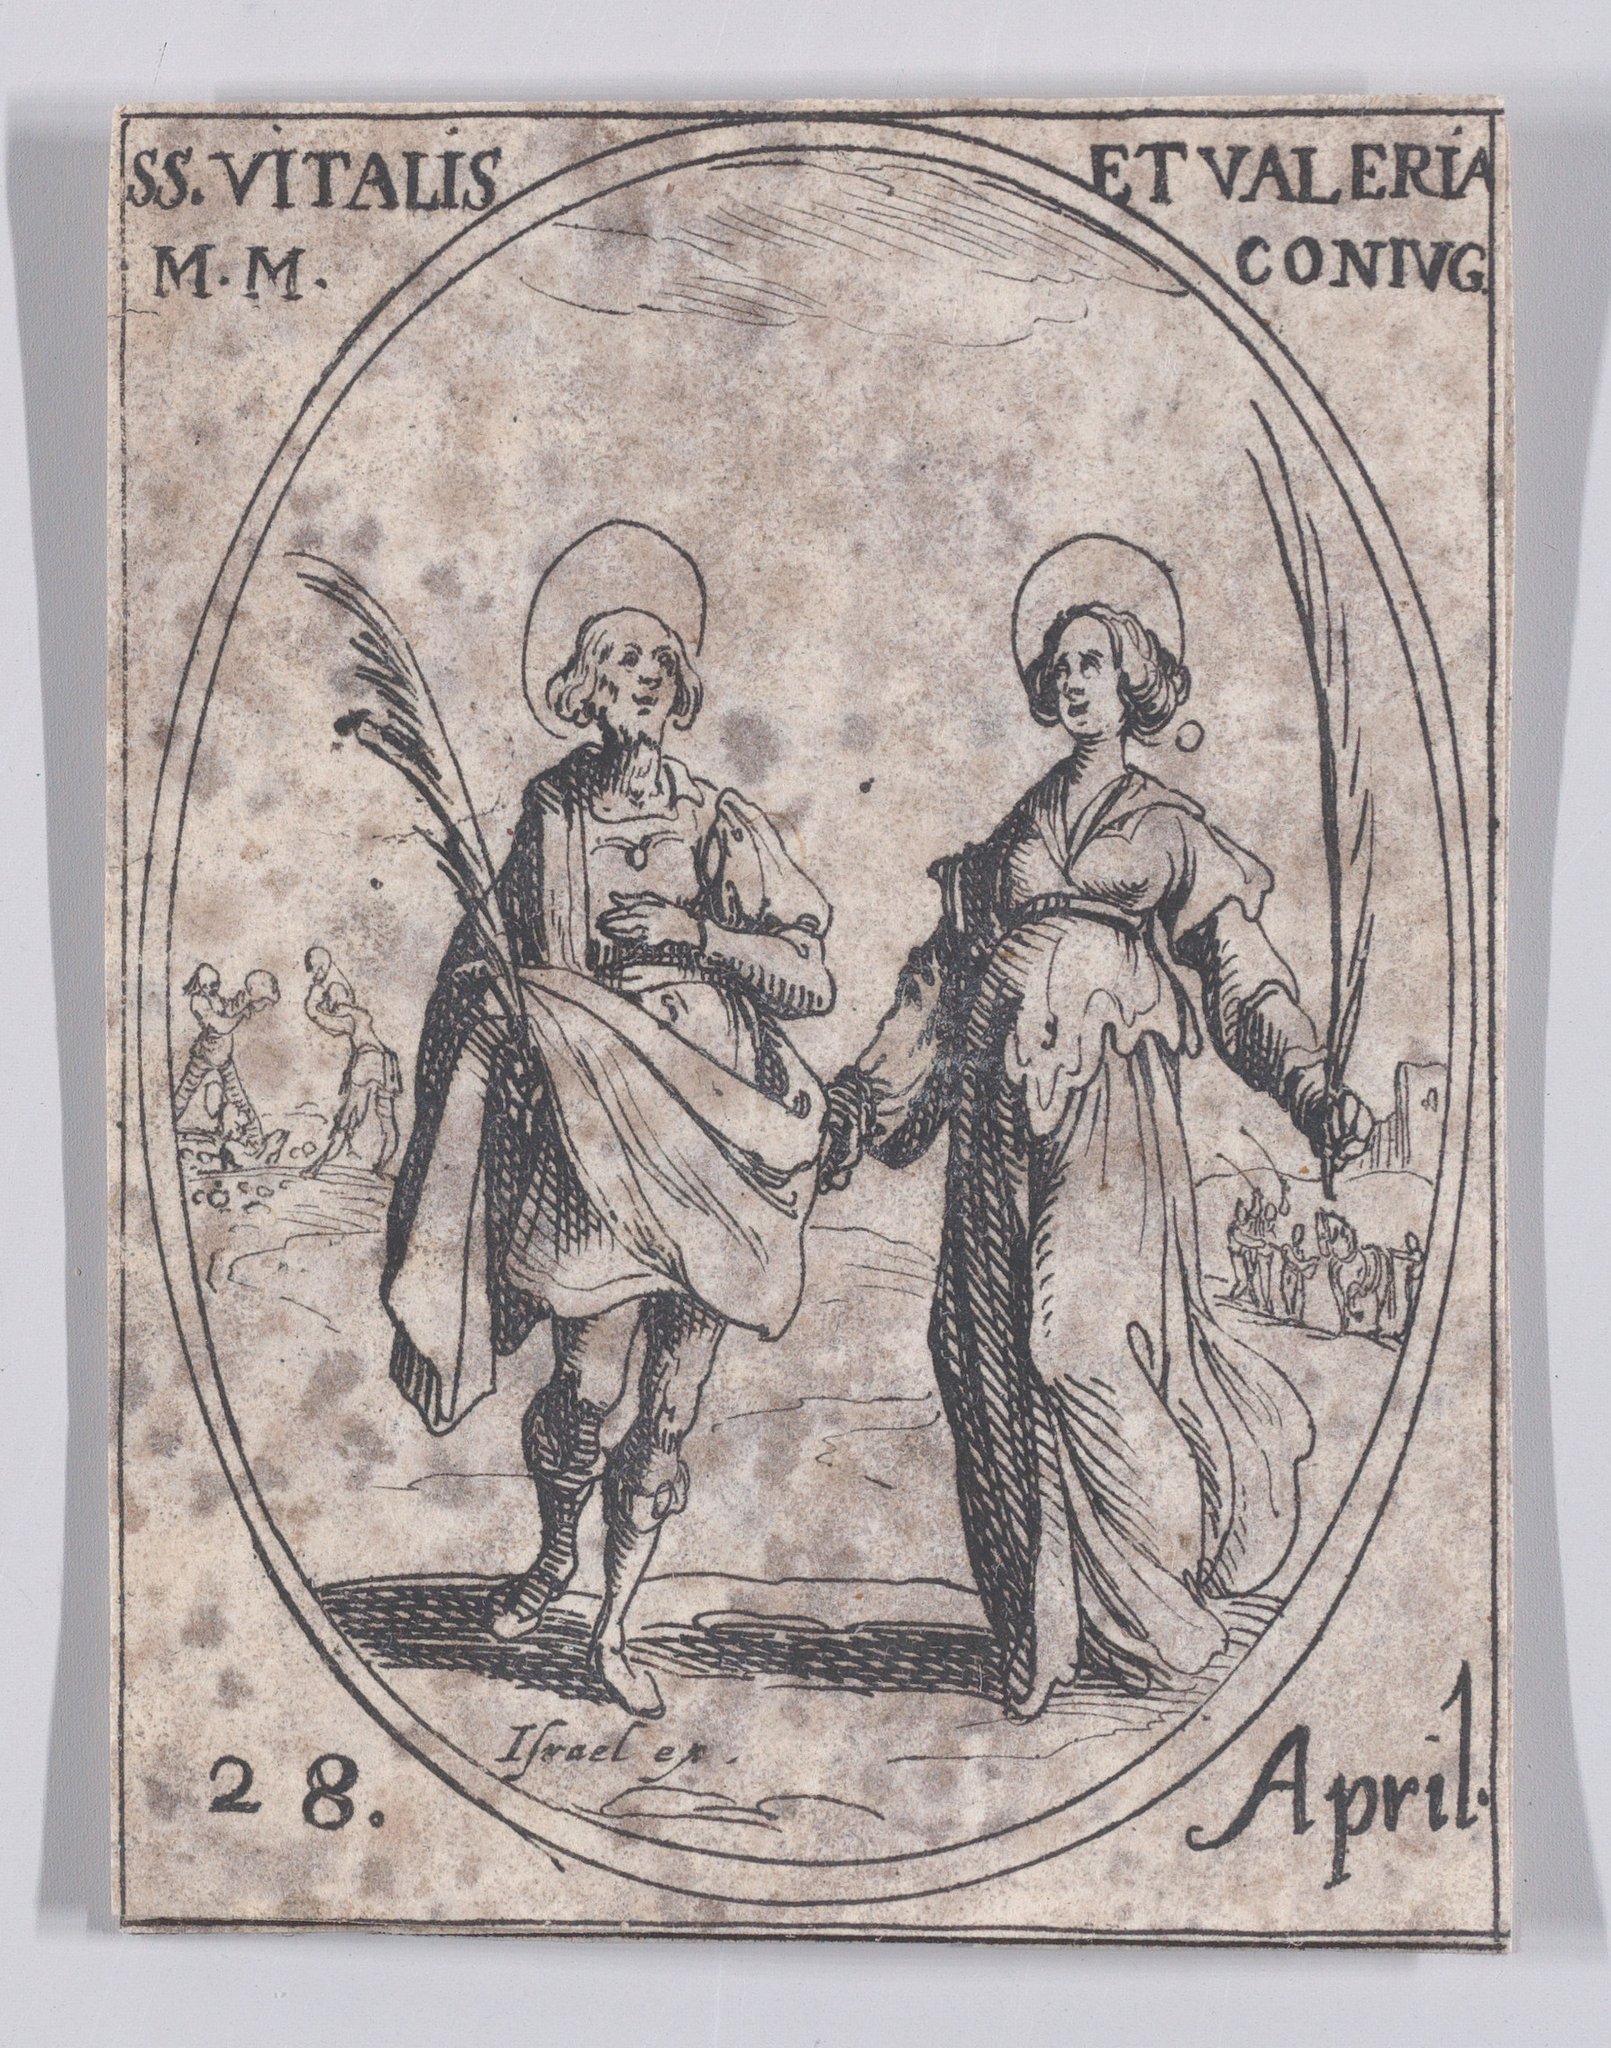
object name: print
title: S. Vital et Ste. Valérie (St. Vitalis and St. Valeria), April 28th, from "Les Images De Tous Les Saincts et Saintes de L'Année" (Images of All of the Saints and Religious Events of the Year)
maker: jacques callot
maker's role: artist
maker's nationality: french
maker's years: 1592-1635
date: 1636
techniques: etching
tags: men,women,saints